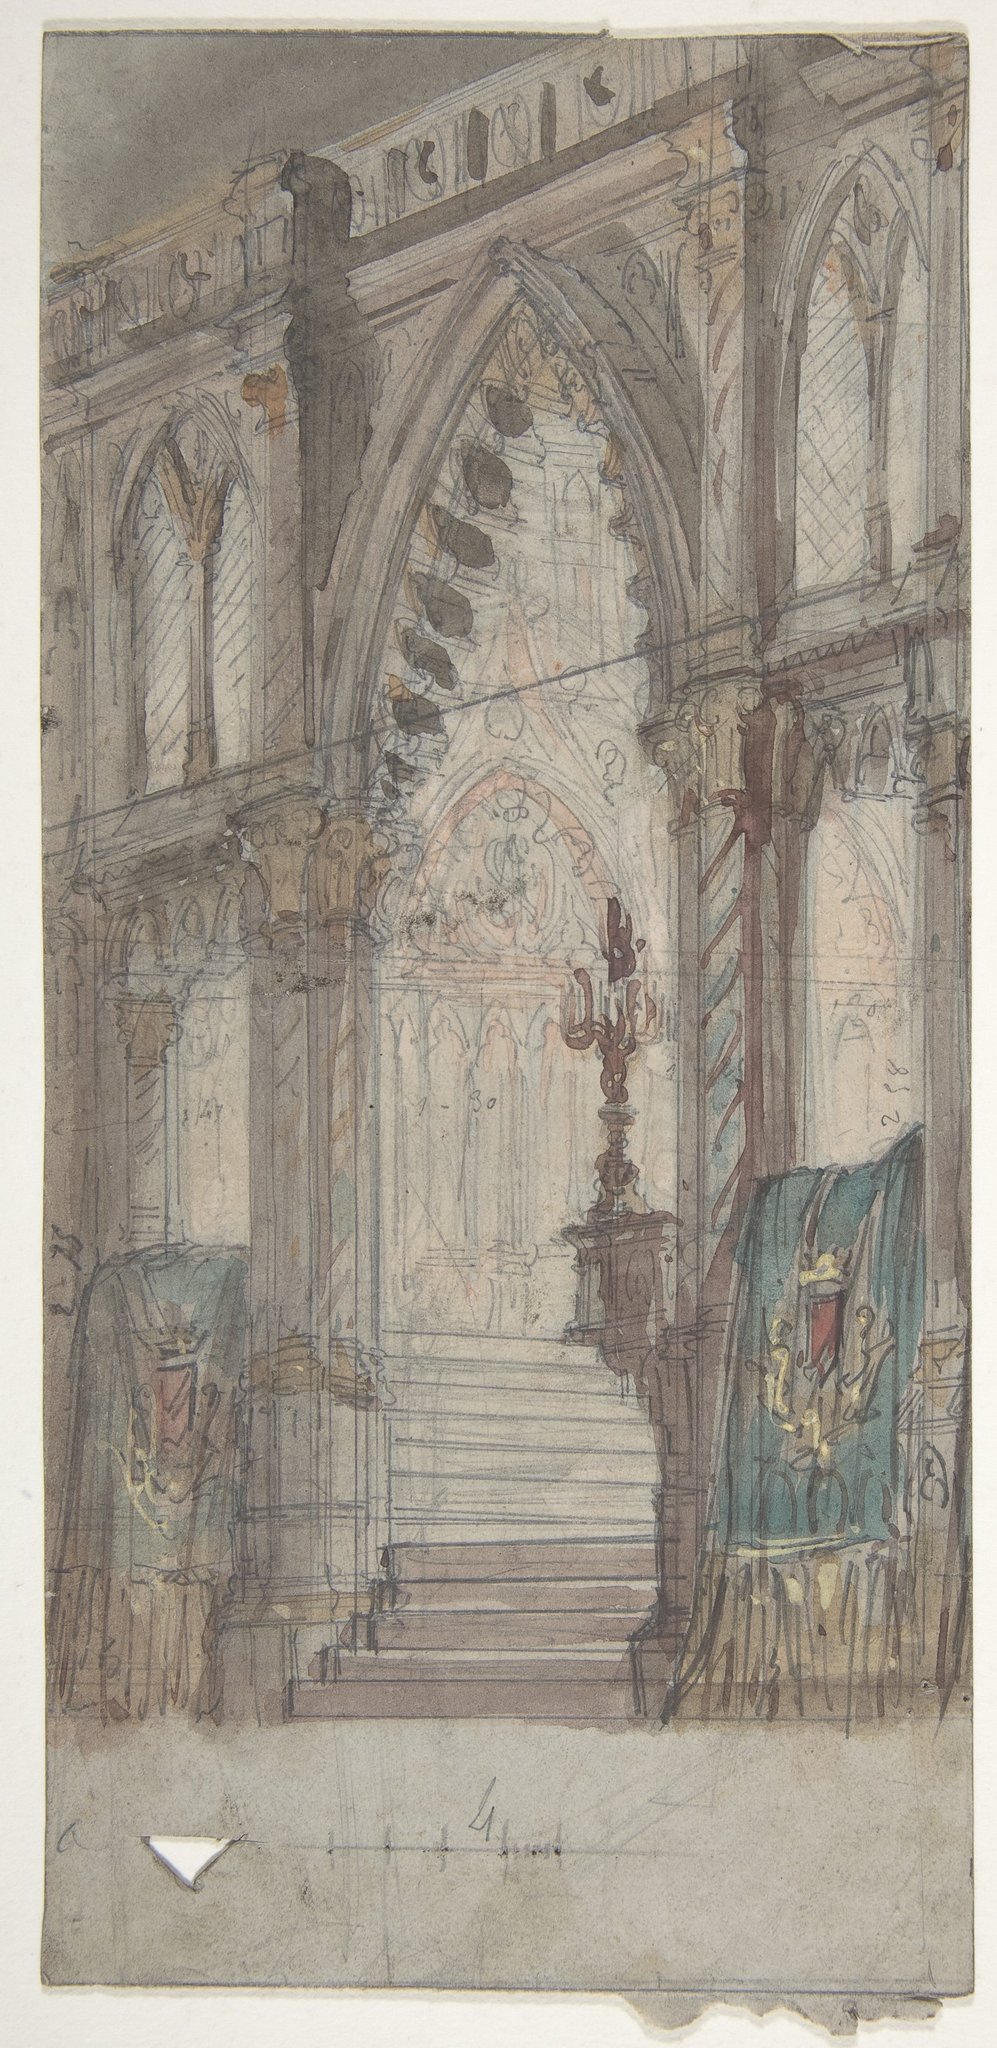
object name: drawing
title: Design for a Stage Set at the Opéra, Paris: Church Interior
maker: eugène cicéri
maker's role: artist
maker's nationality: french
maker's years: 1813-1890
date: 1830-1890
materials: gouache, graphite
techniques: brush, wash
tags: interiors,churches,stage design